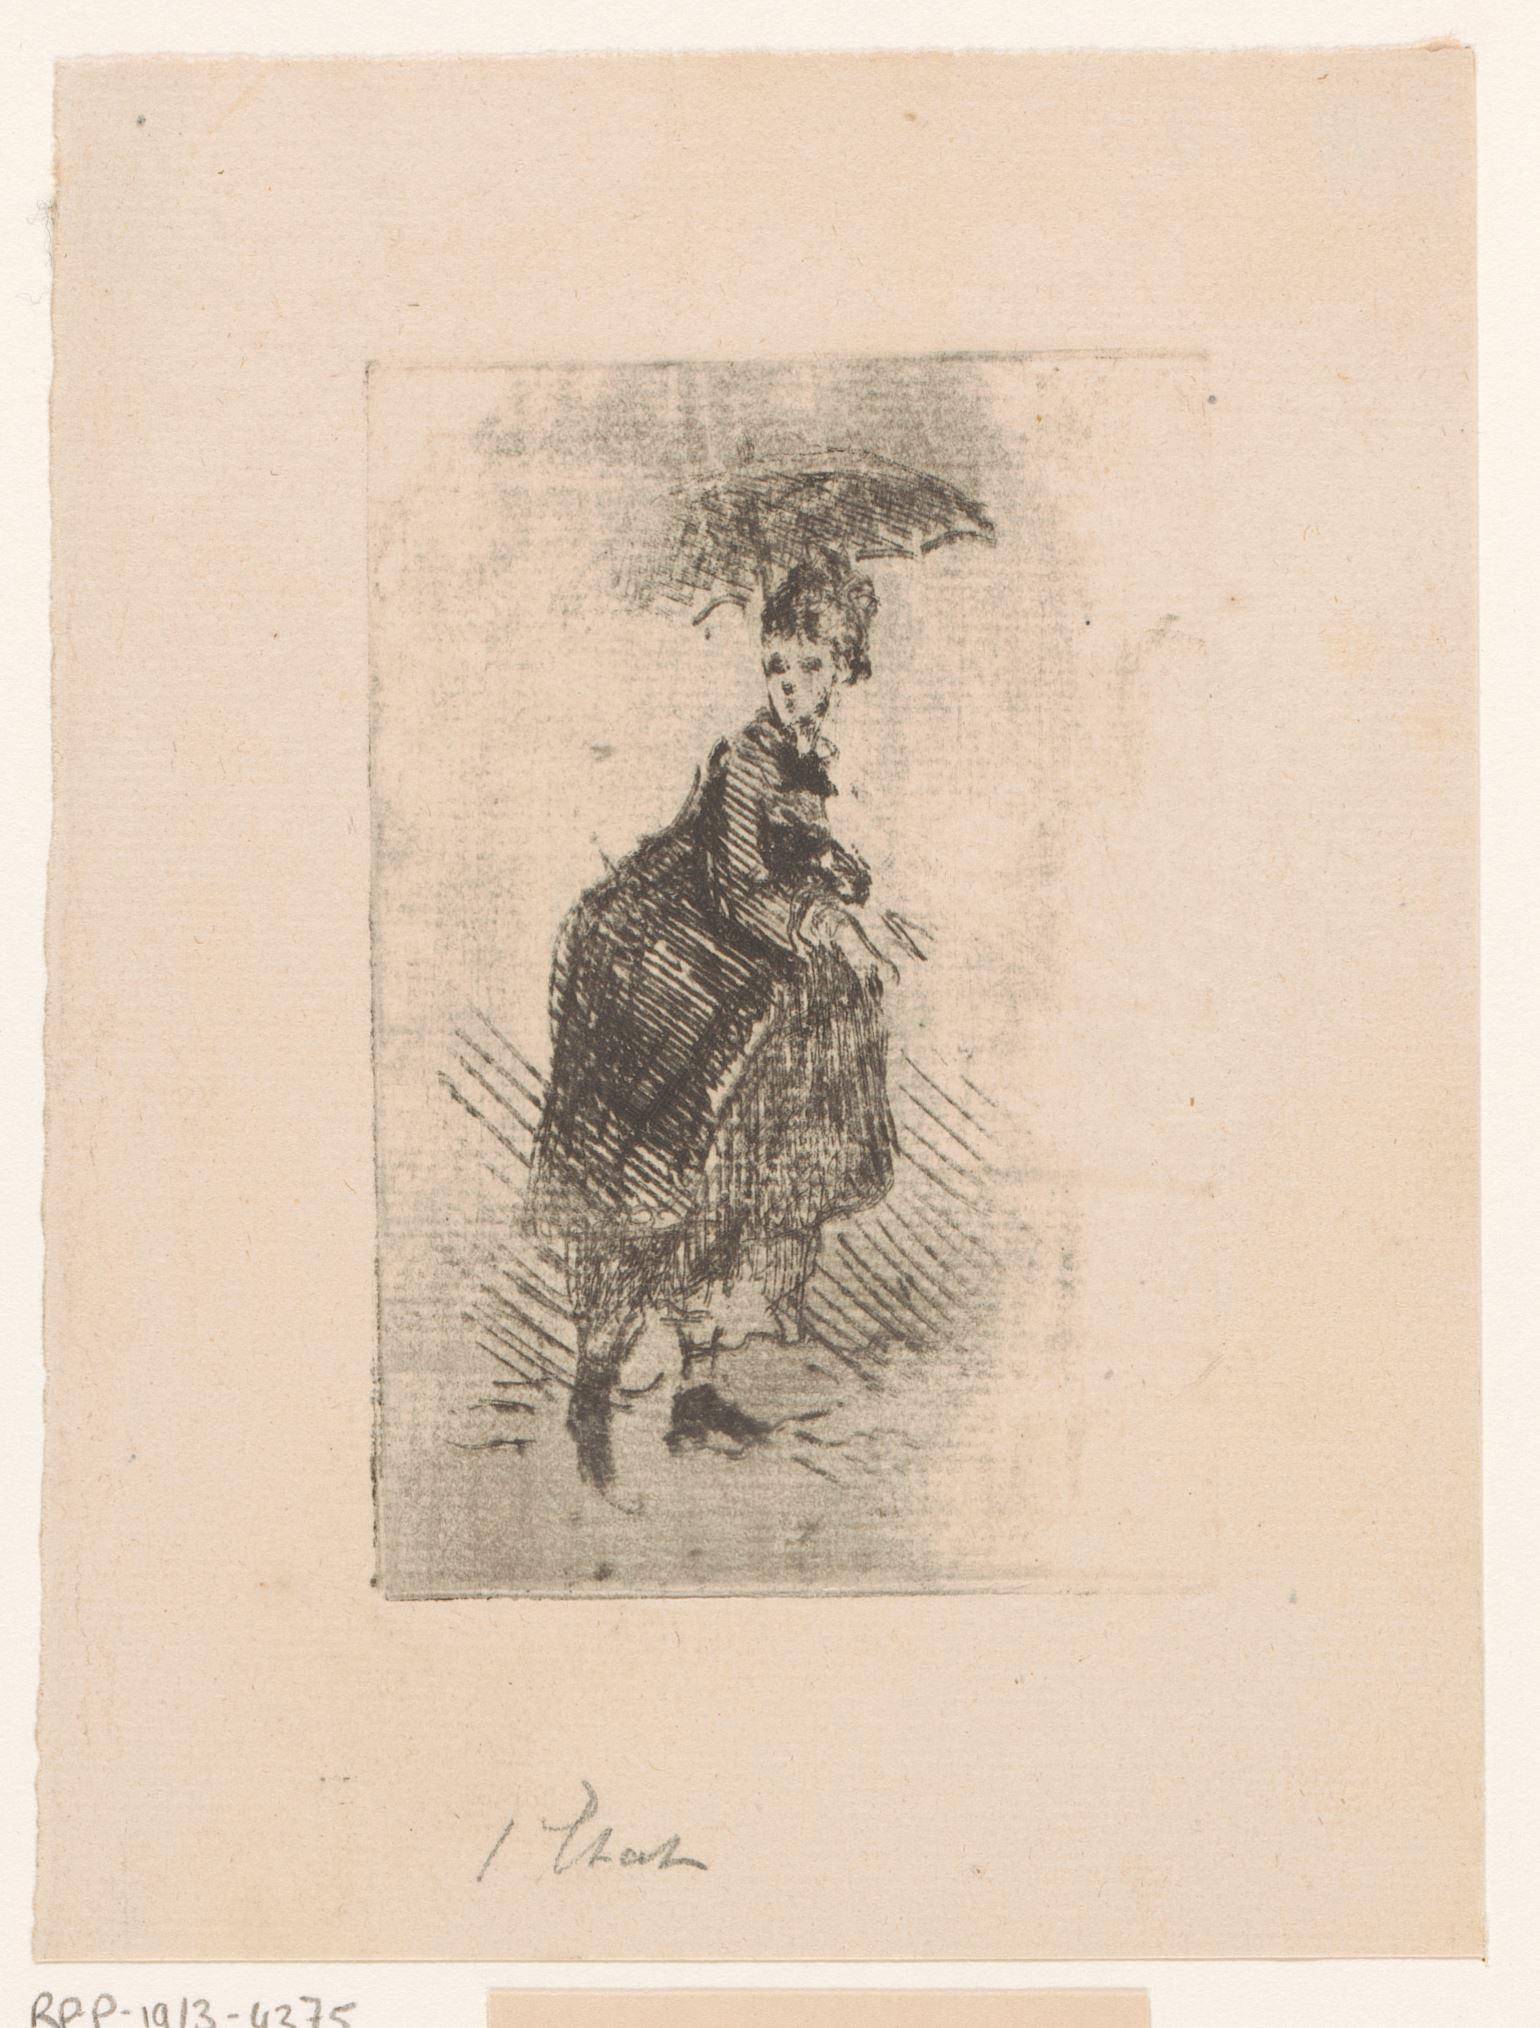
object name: print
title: Vrouw met paraplu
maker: adrien de witte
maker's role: print maker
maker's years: 1850-1935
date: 1860-1913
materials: paper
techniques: drypoint, etching, intaglio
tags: adult woman, umbrella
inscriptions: collector's mark: Lugt 2228